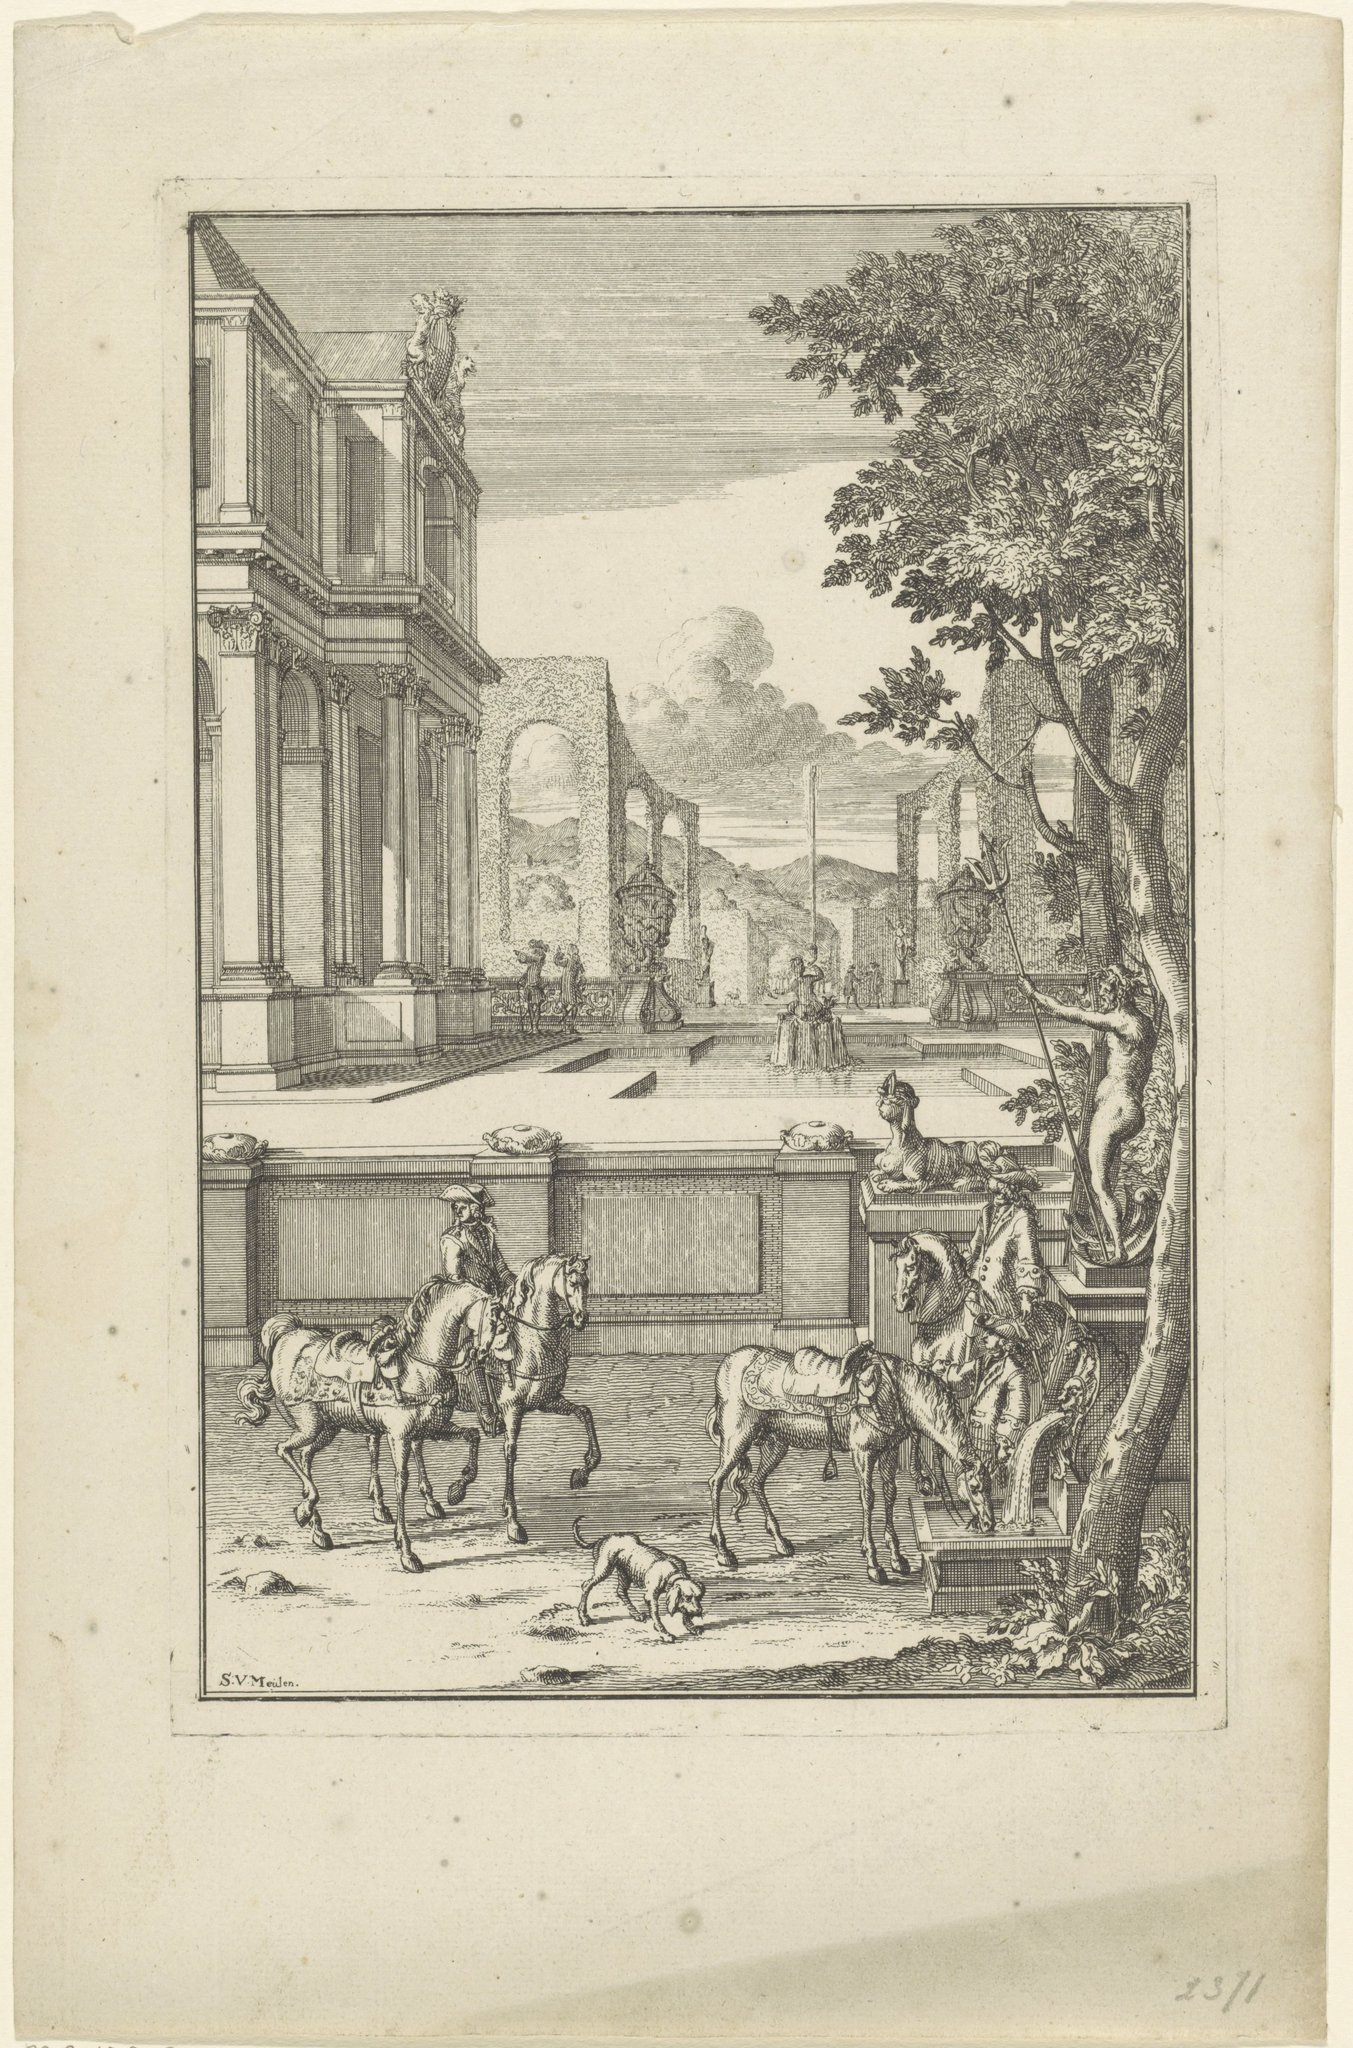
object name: print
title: Gesigten en Perspectiven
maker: sieuwert van der meulen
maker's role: draughtsman, print maker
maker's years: 1683-1730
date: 1707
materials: paper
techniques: etching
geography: netherlands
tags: garden fountain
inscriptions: collector's mark: Lugt 2228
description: Gezicht in een formele tuin met een vijver met fontein. Links een gebouw. Op de voorgrond ruiters.